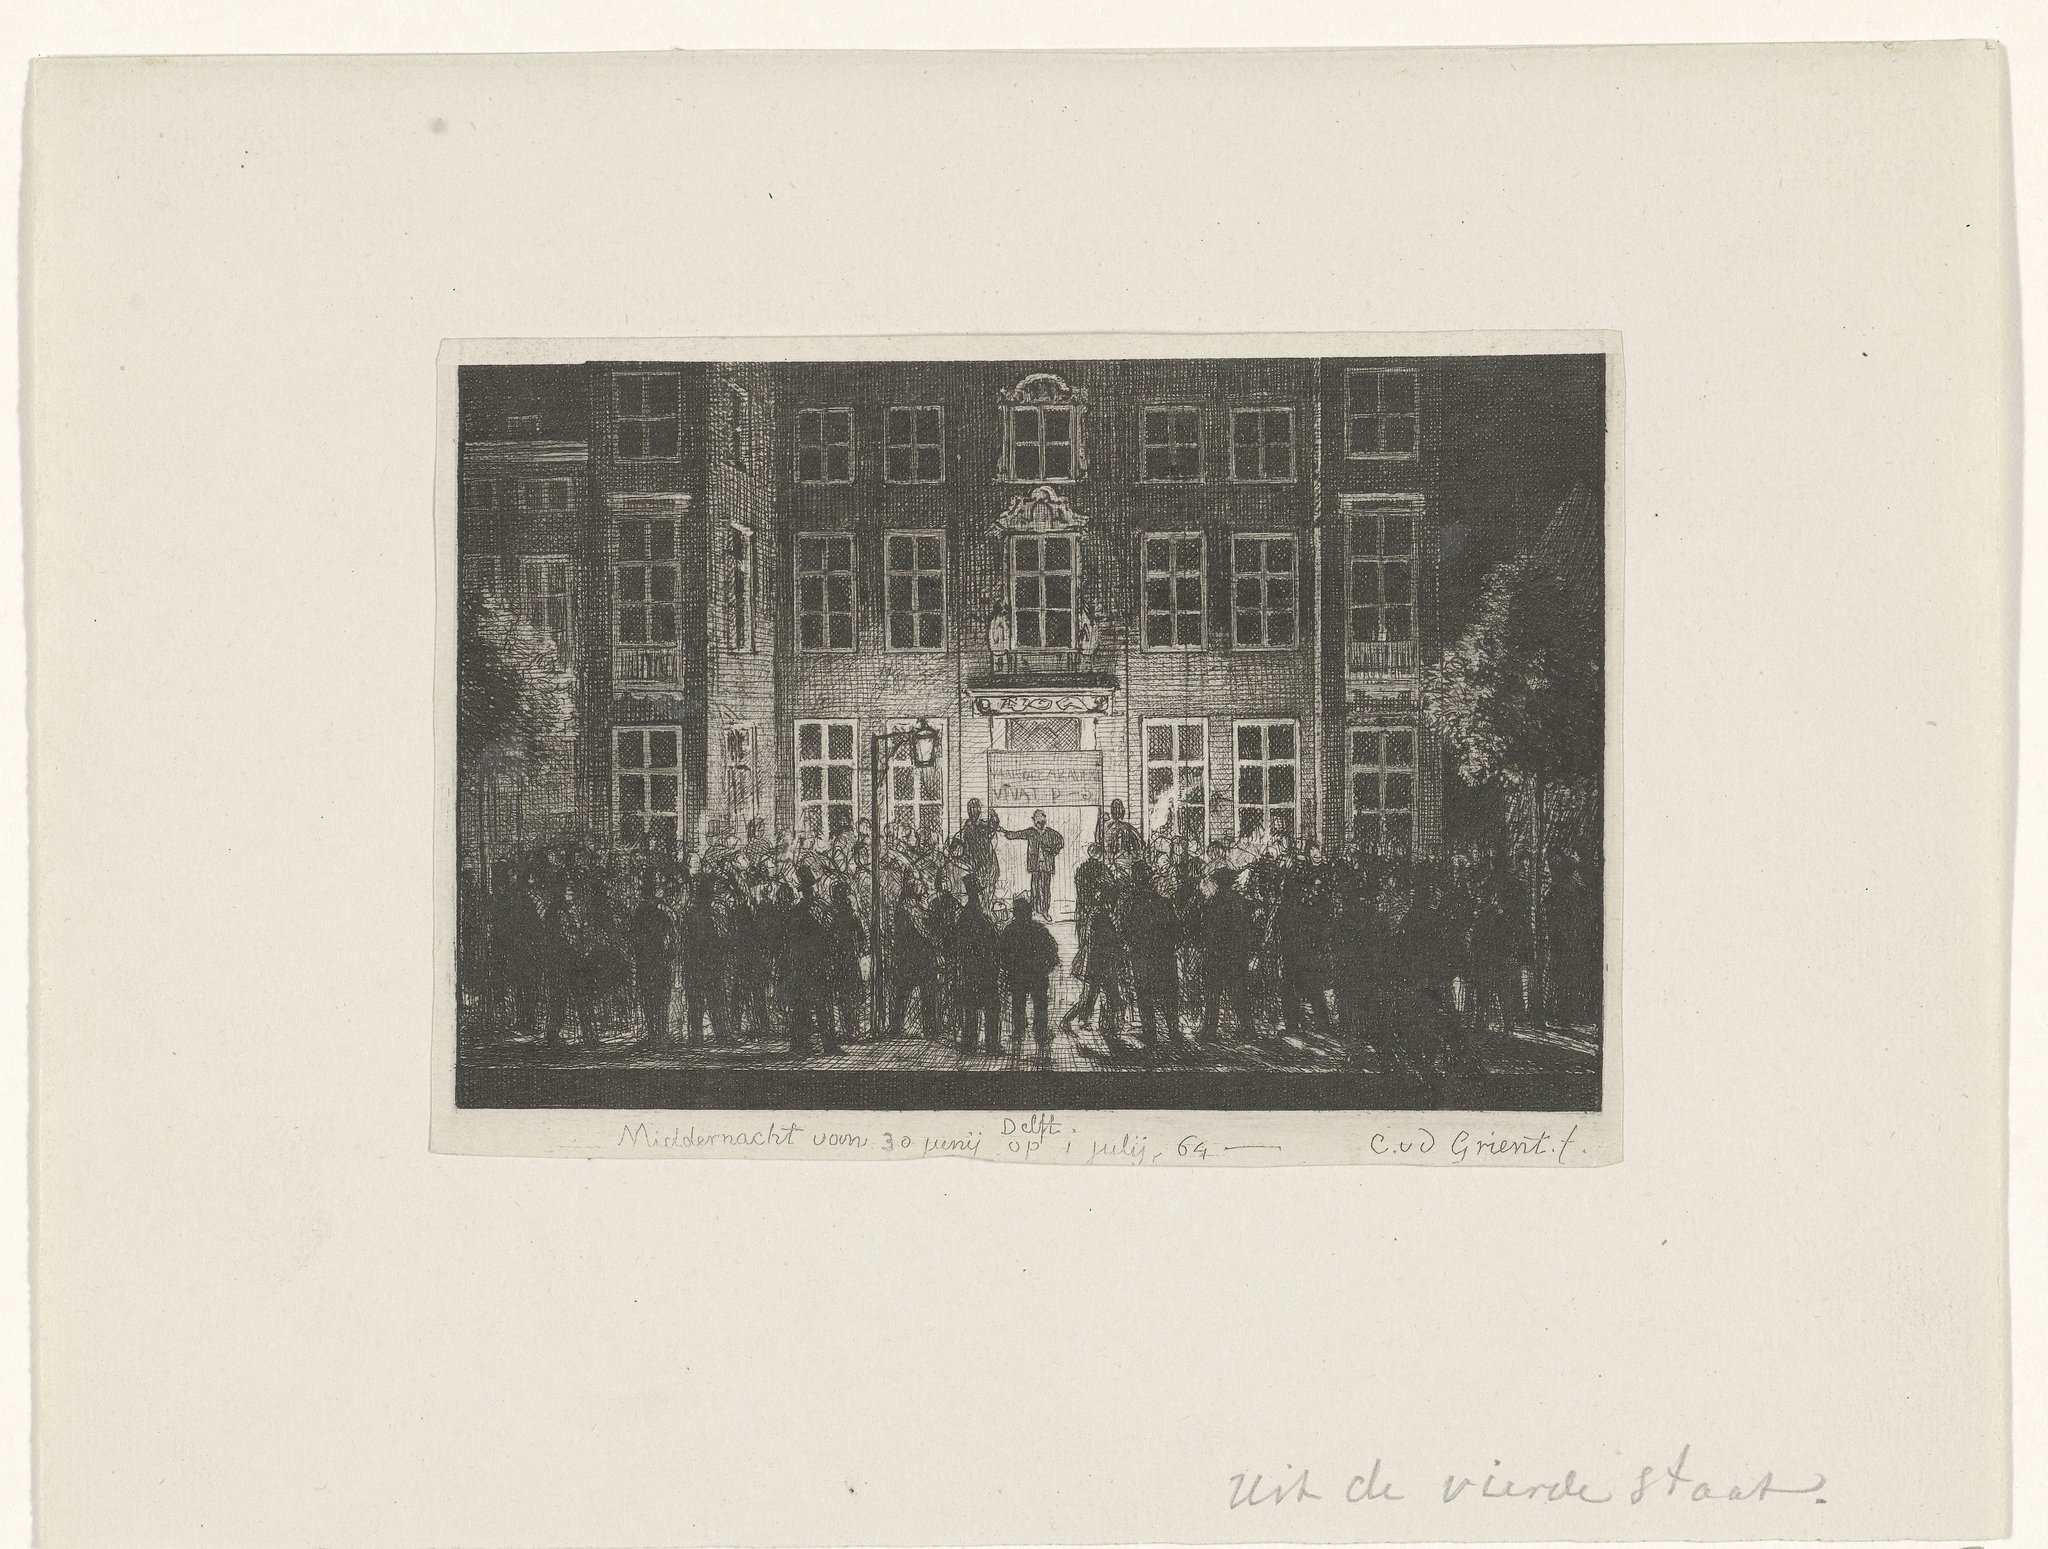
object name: print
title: Begrafenis van de Delftsche academie, 30 juni 1864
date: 1864-1866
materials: paper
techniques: drypoint, etching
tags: funerary ceremonial, delft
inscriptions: collector's mark: Lugt 2228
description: Illuminatie van een huis te Delft, middernacht van 30 juni op 1 juli 1864. Een groep studenten verzameld voor een verlicht huis aan een gracht. Boven de deur van het huis een bord met het opschrift 'Akademia VIVAT P - S'. Bij de naamsverandering van de Delftsche Akademie in de Delftsche Polytechnische School.